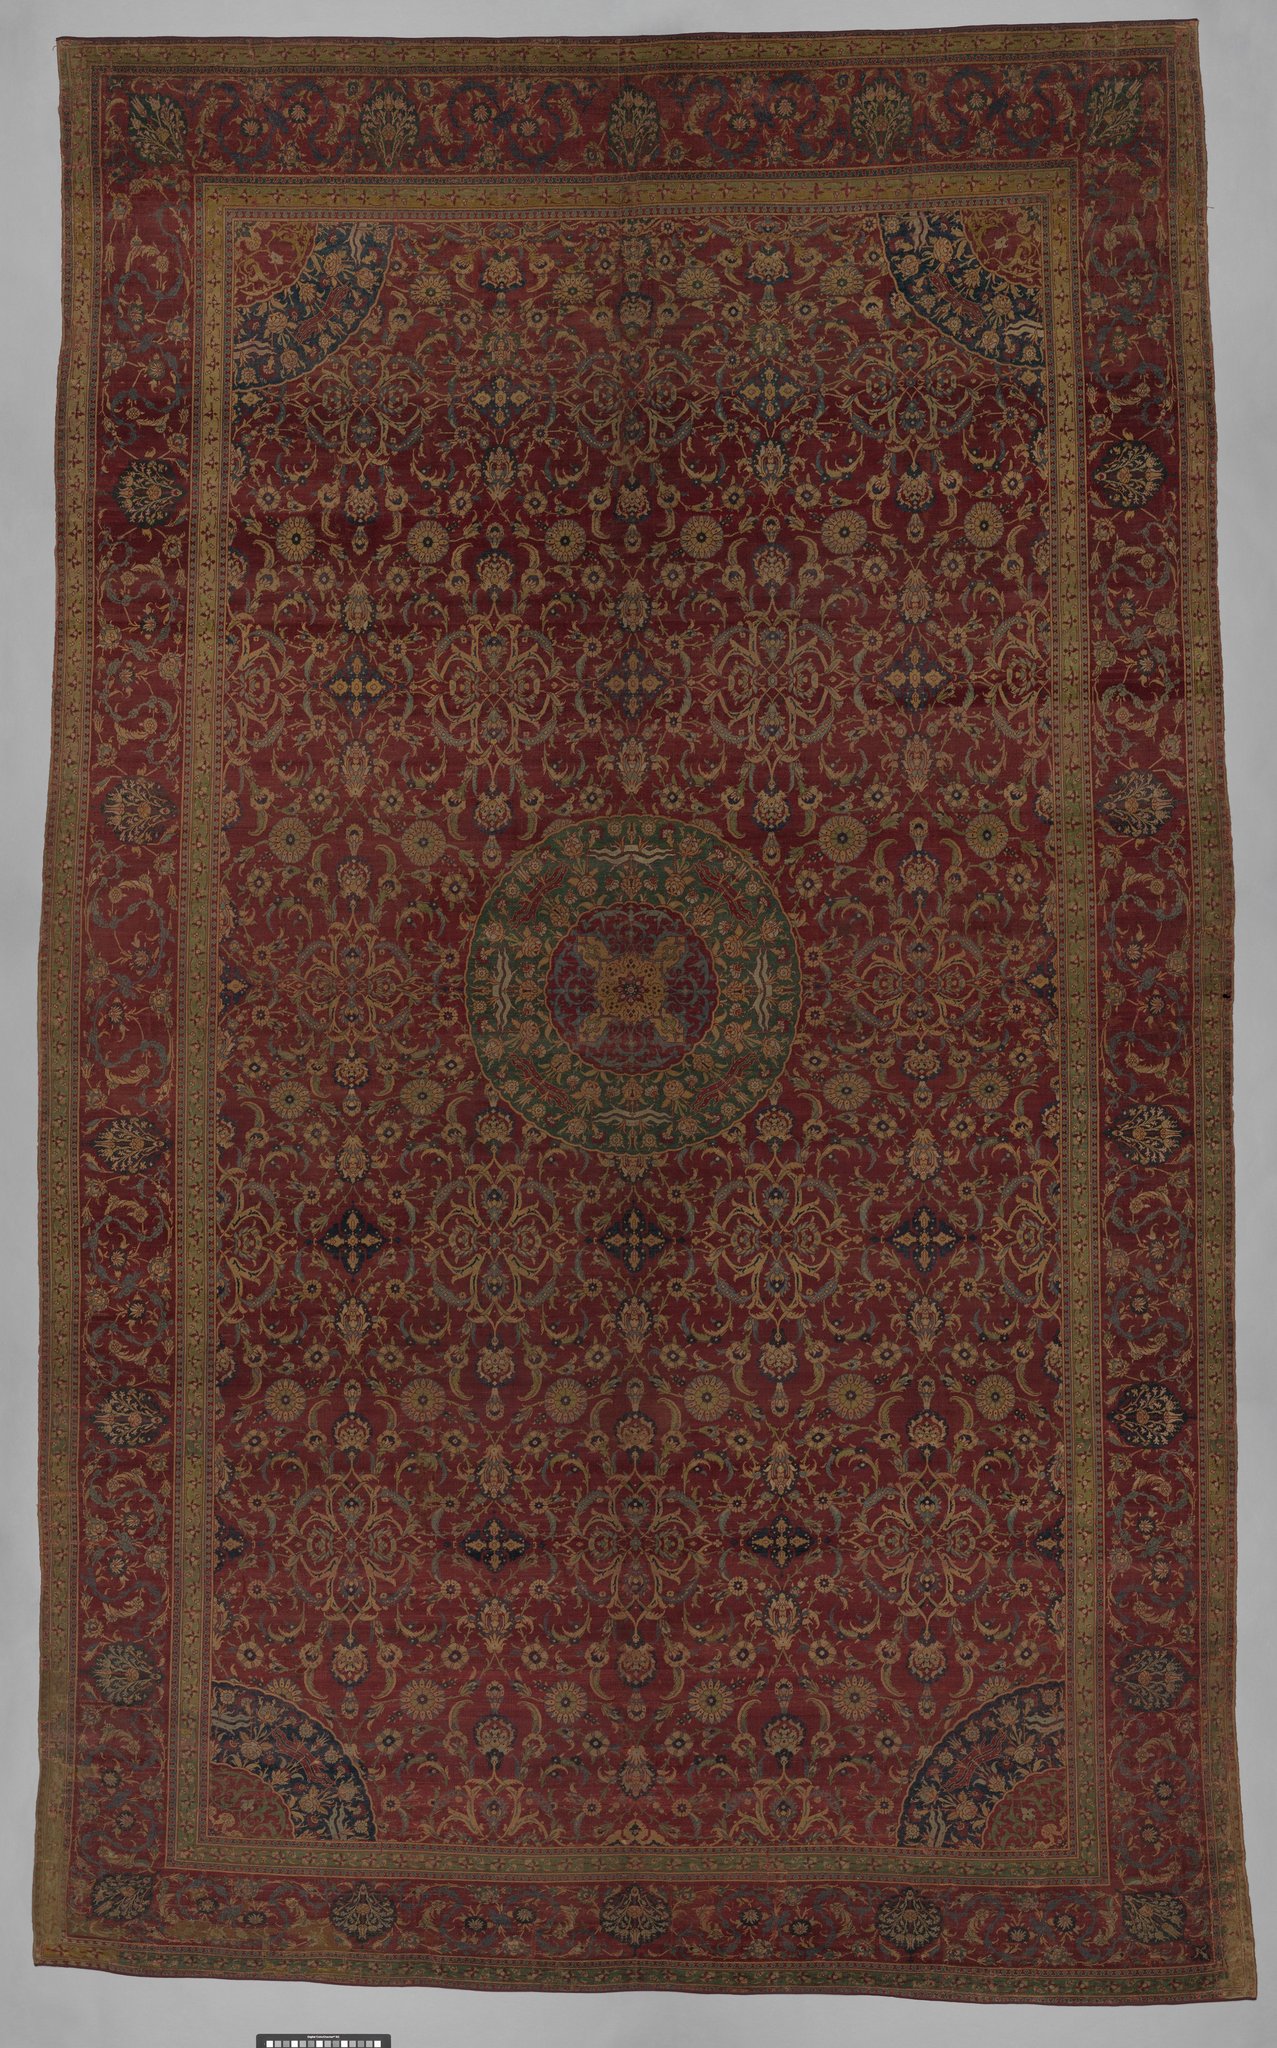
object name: carpet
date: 1576-1600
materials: silk, wool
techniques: asymmetrically knotted pile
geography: egypt